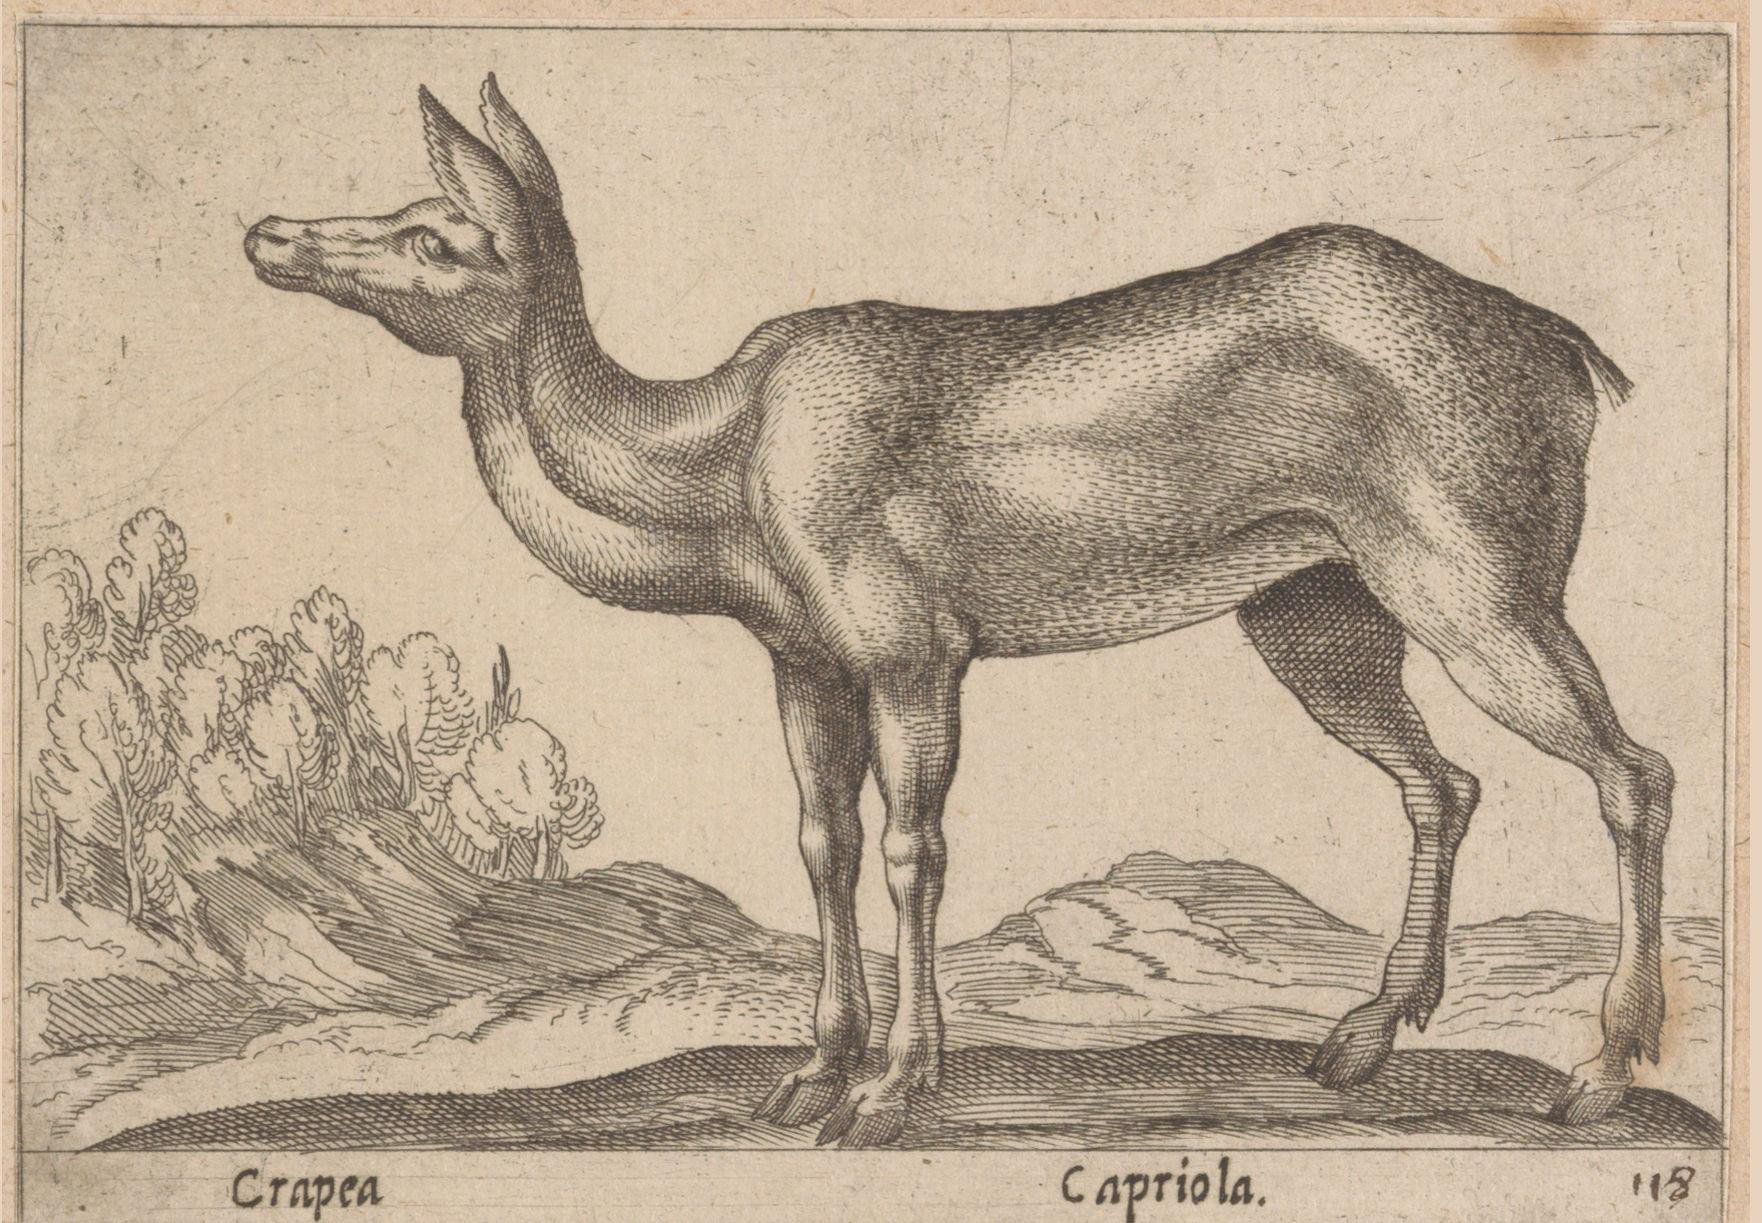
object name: print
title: Ree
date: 1565-1630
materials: paper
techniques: etching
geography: italy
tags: hoofed animals: deer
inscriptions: number: ‘118’, collector's mark: Lugt 11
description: Deze prent maakt deel uit van een reeks prenten van dieren door Antonio Tempesta. Bekend is dat een tweede staat (met nummering) van deze serie is uitgegeven door Giovanni Giacomo de' Rossi in 1650. Onbekend is wie de eerste staat heeft uitgegeven en wanneer.